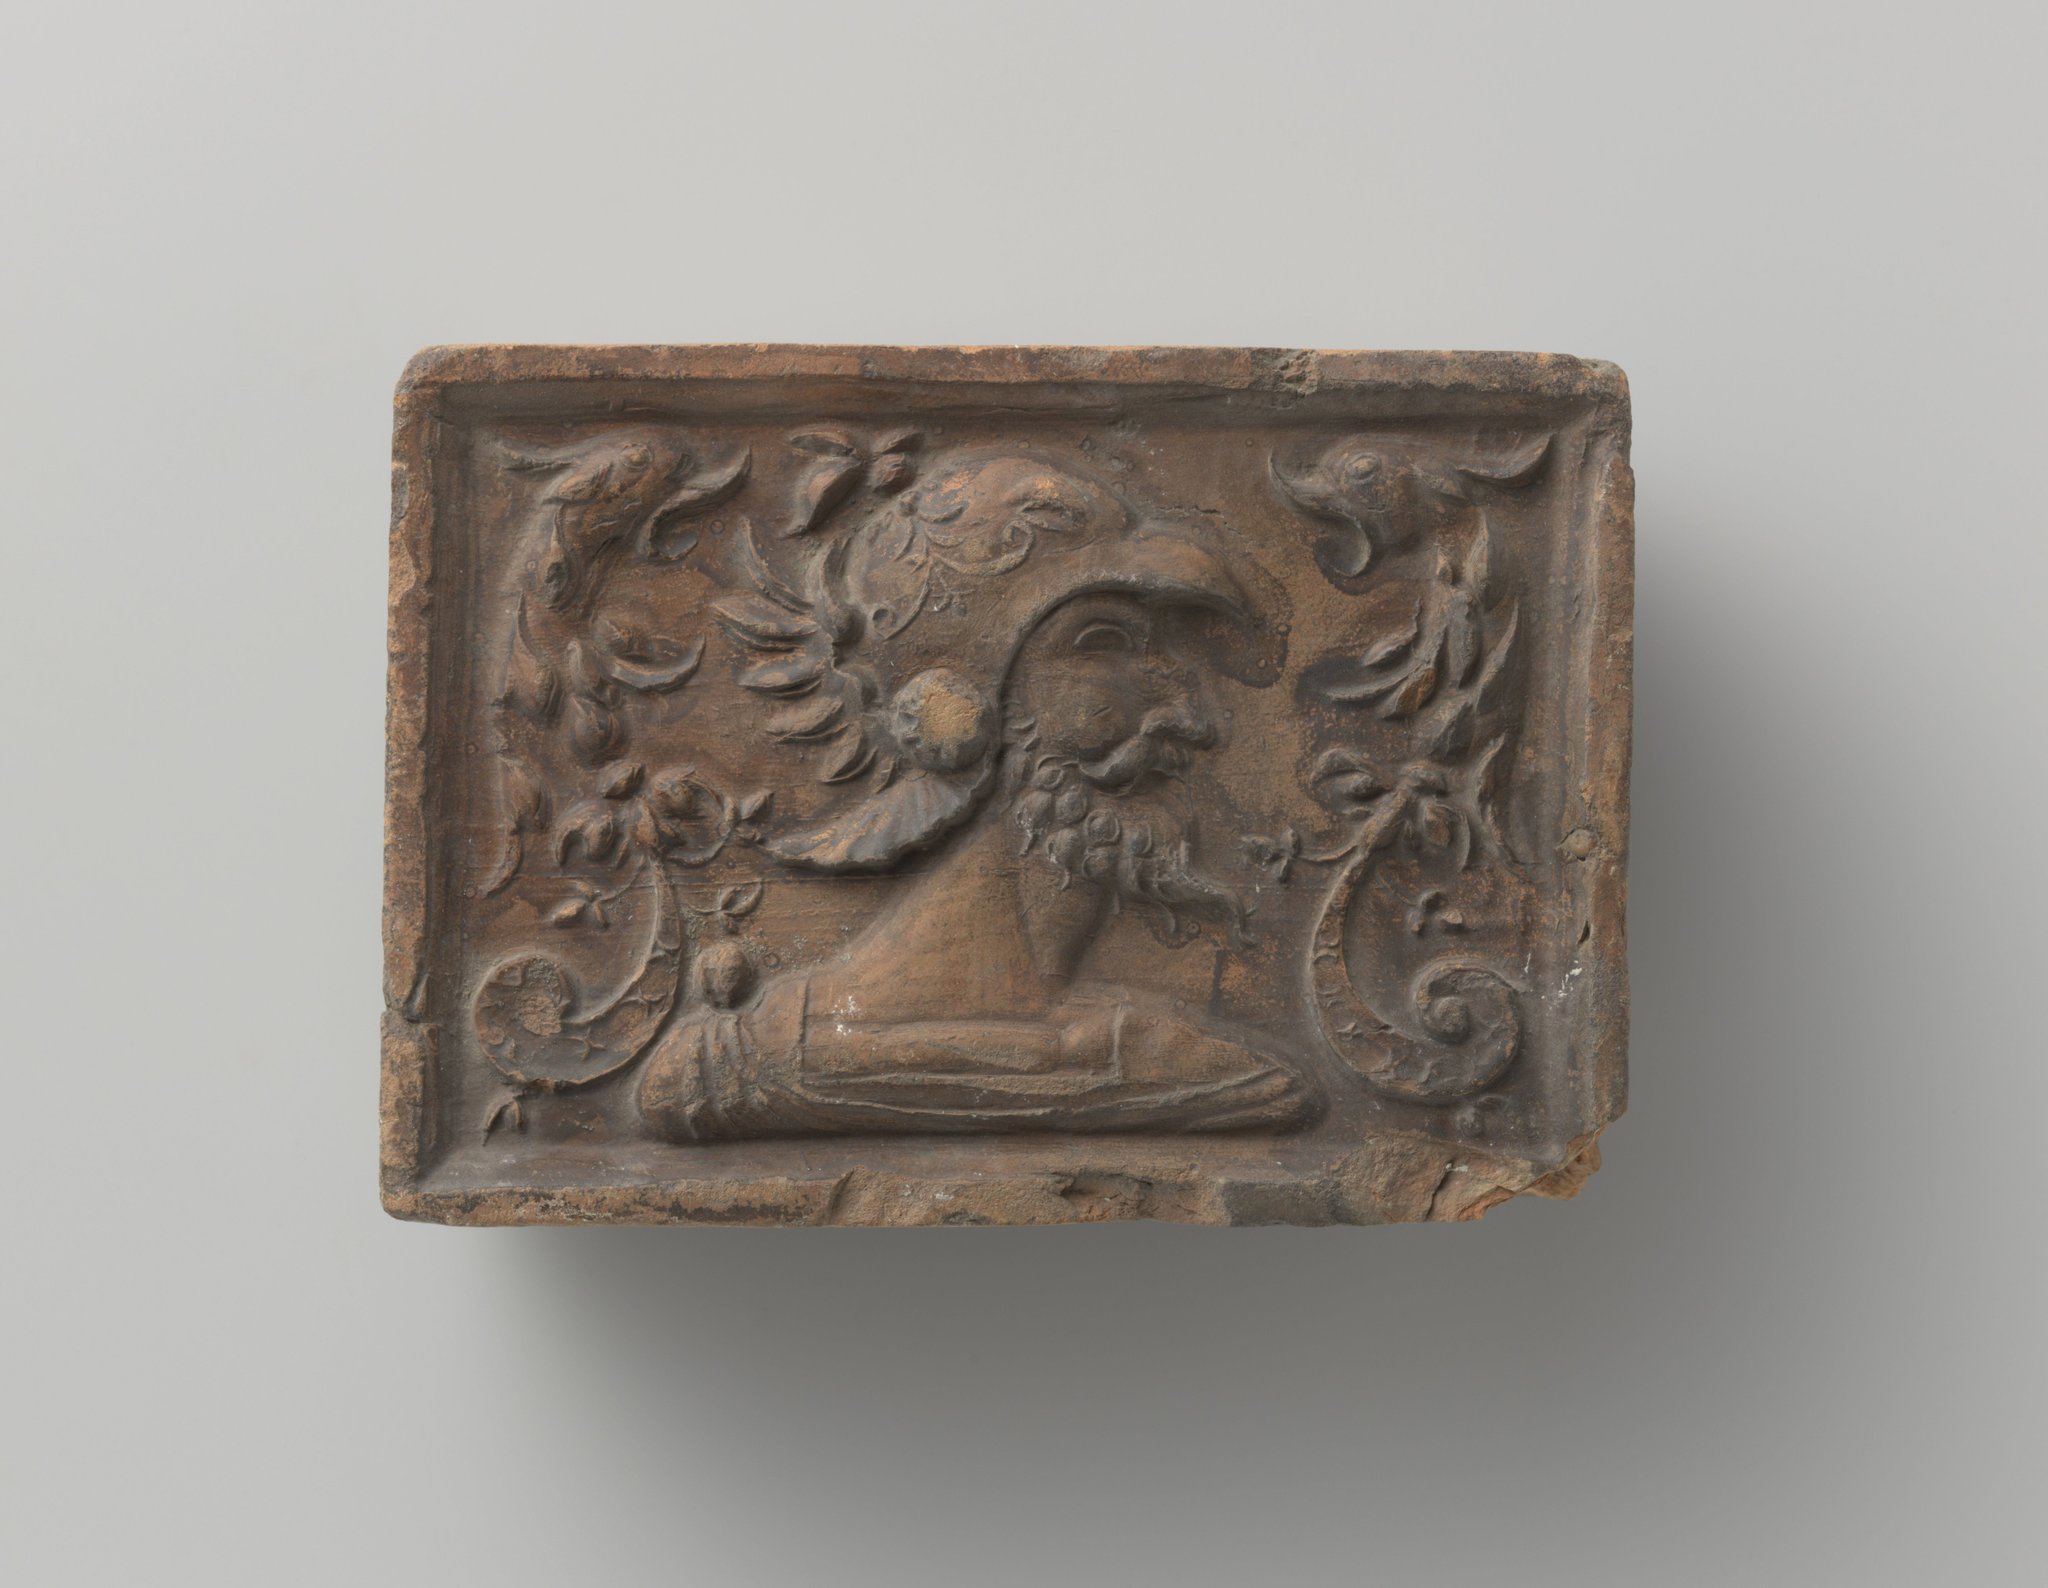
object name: hearthstone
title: Haardsteen met een hoofd van een Romeinse krijgsman met helm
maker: Anonymous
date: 1500-1600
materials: earthenware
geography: southern netherlands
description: Haardsteen met een hoofd van een Romeinse krijgsman met helm, rechts ziende. Links en rechts chimères.